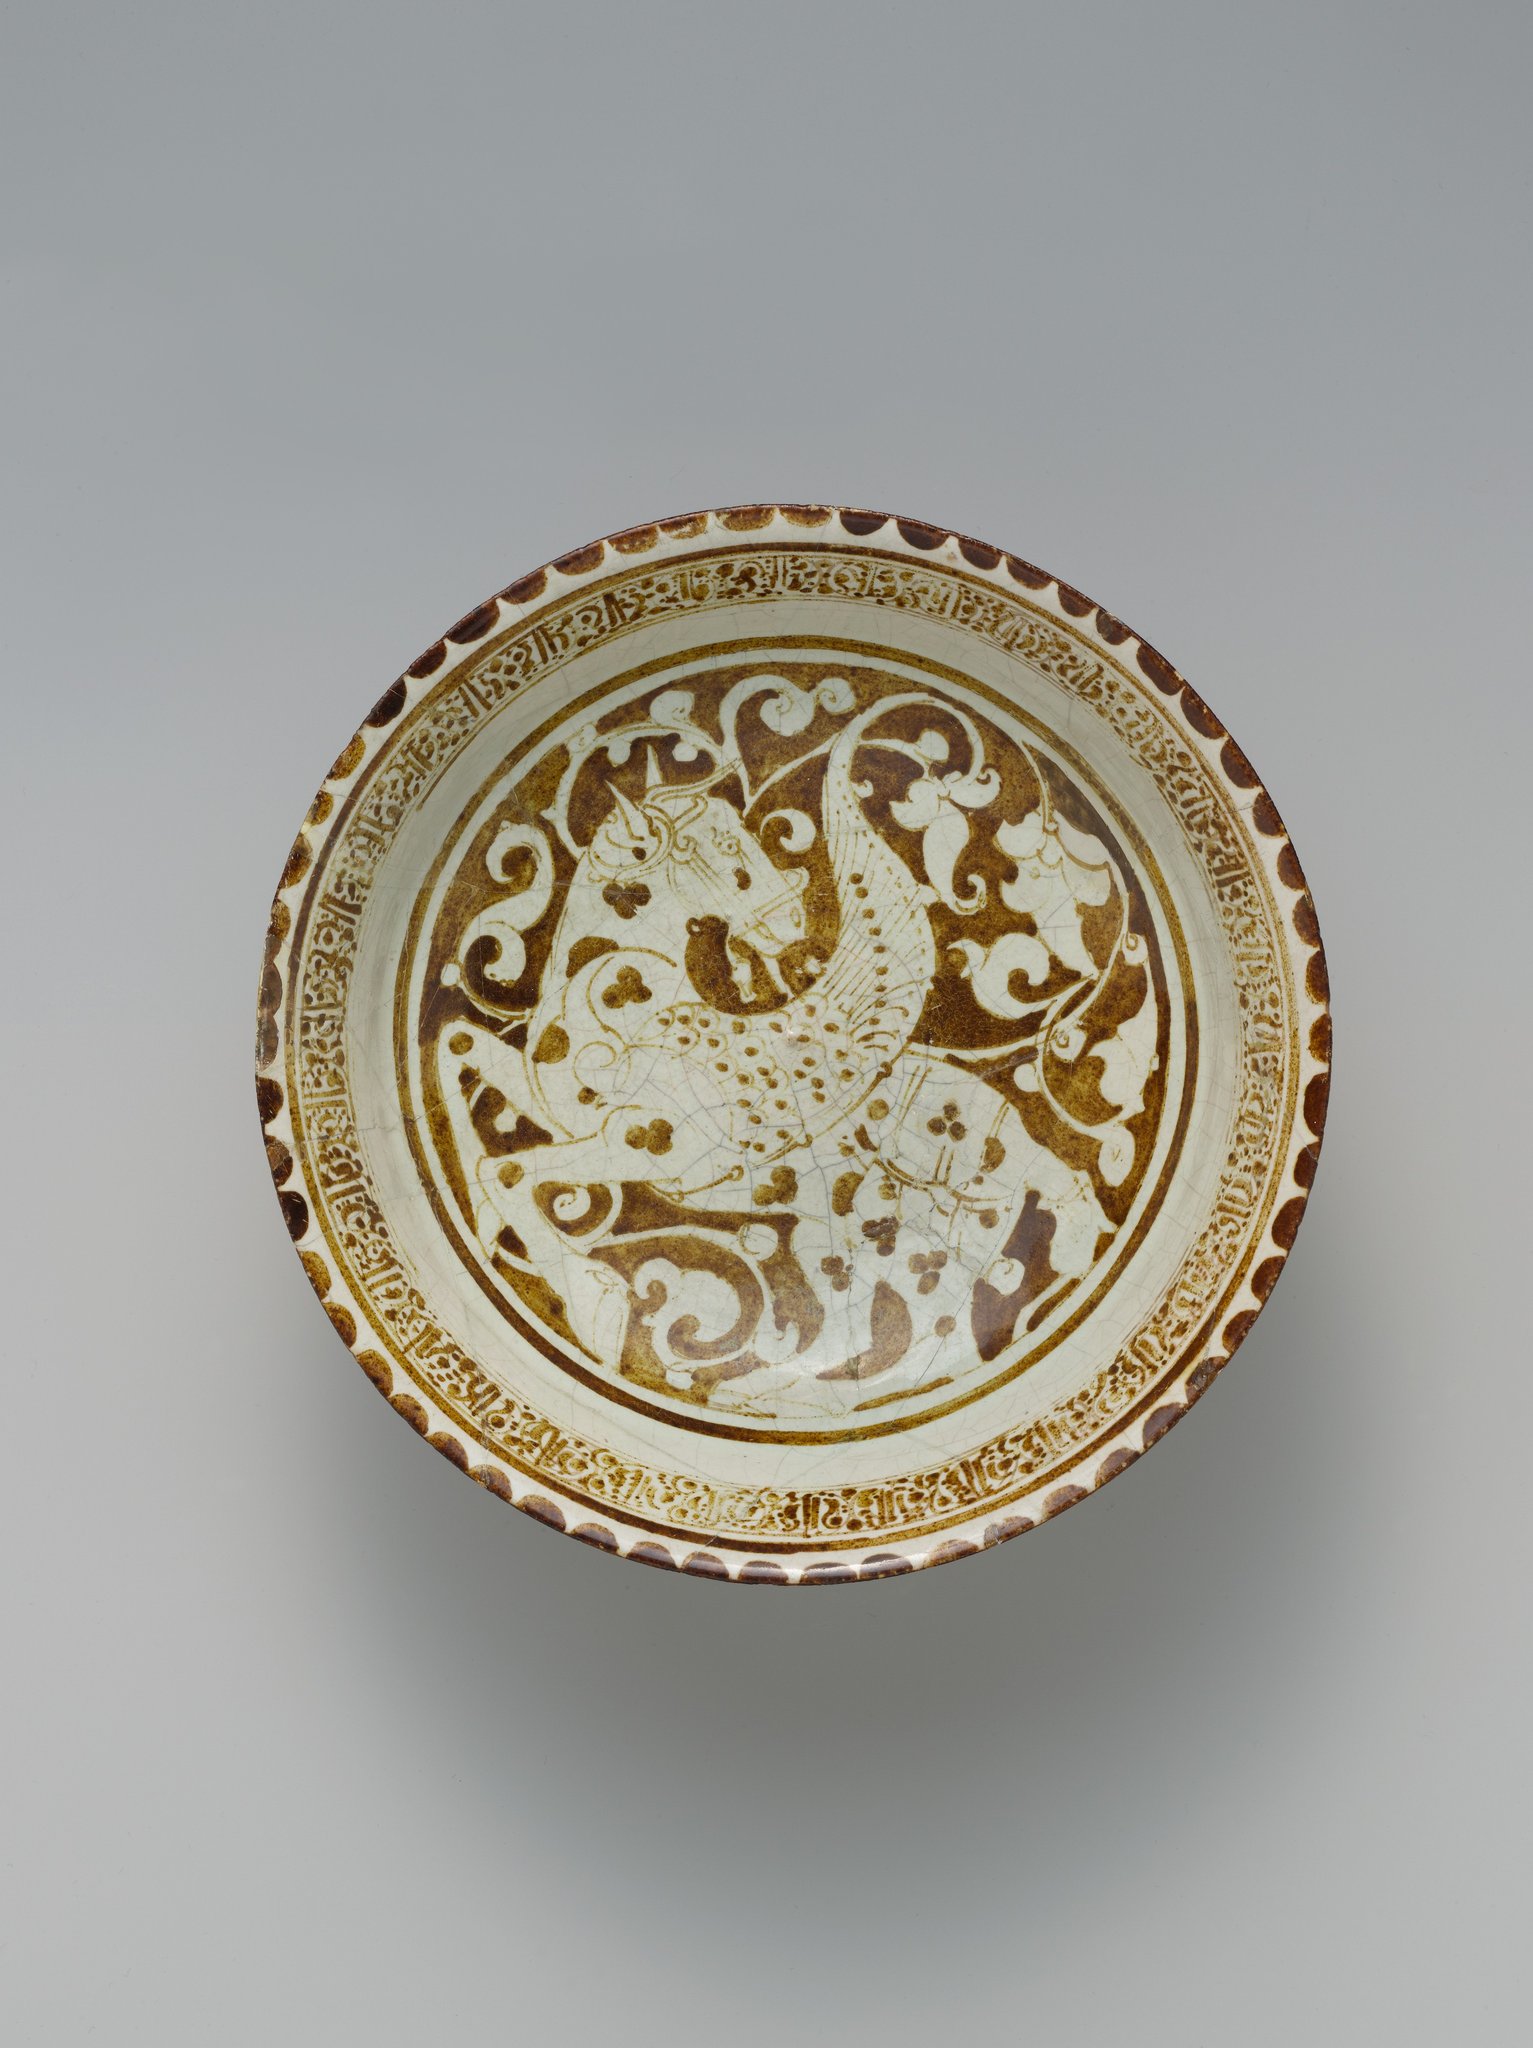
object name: bowl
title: Luster Bowl with Winged Horse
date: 1167-1200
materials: glaze, stonepaste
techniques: luster painting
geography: iran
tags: mythical creatures,horses